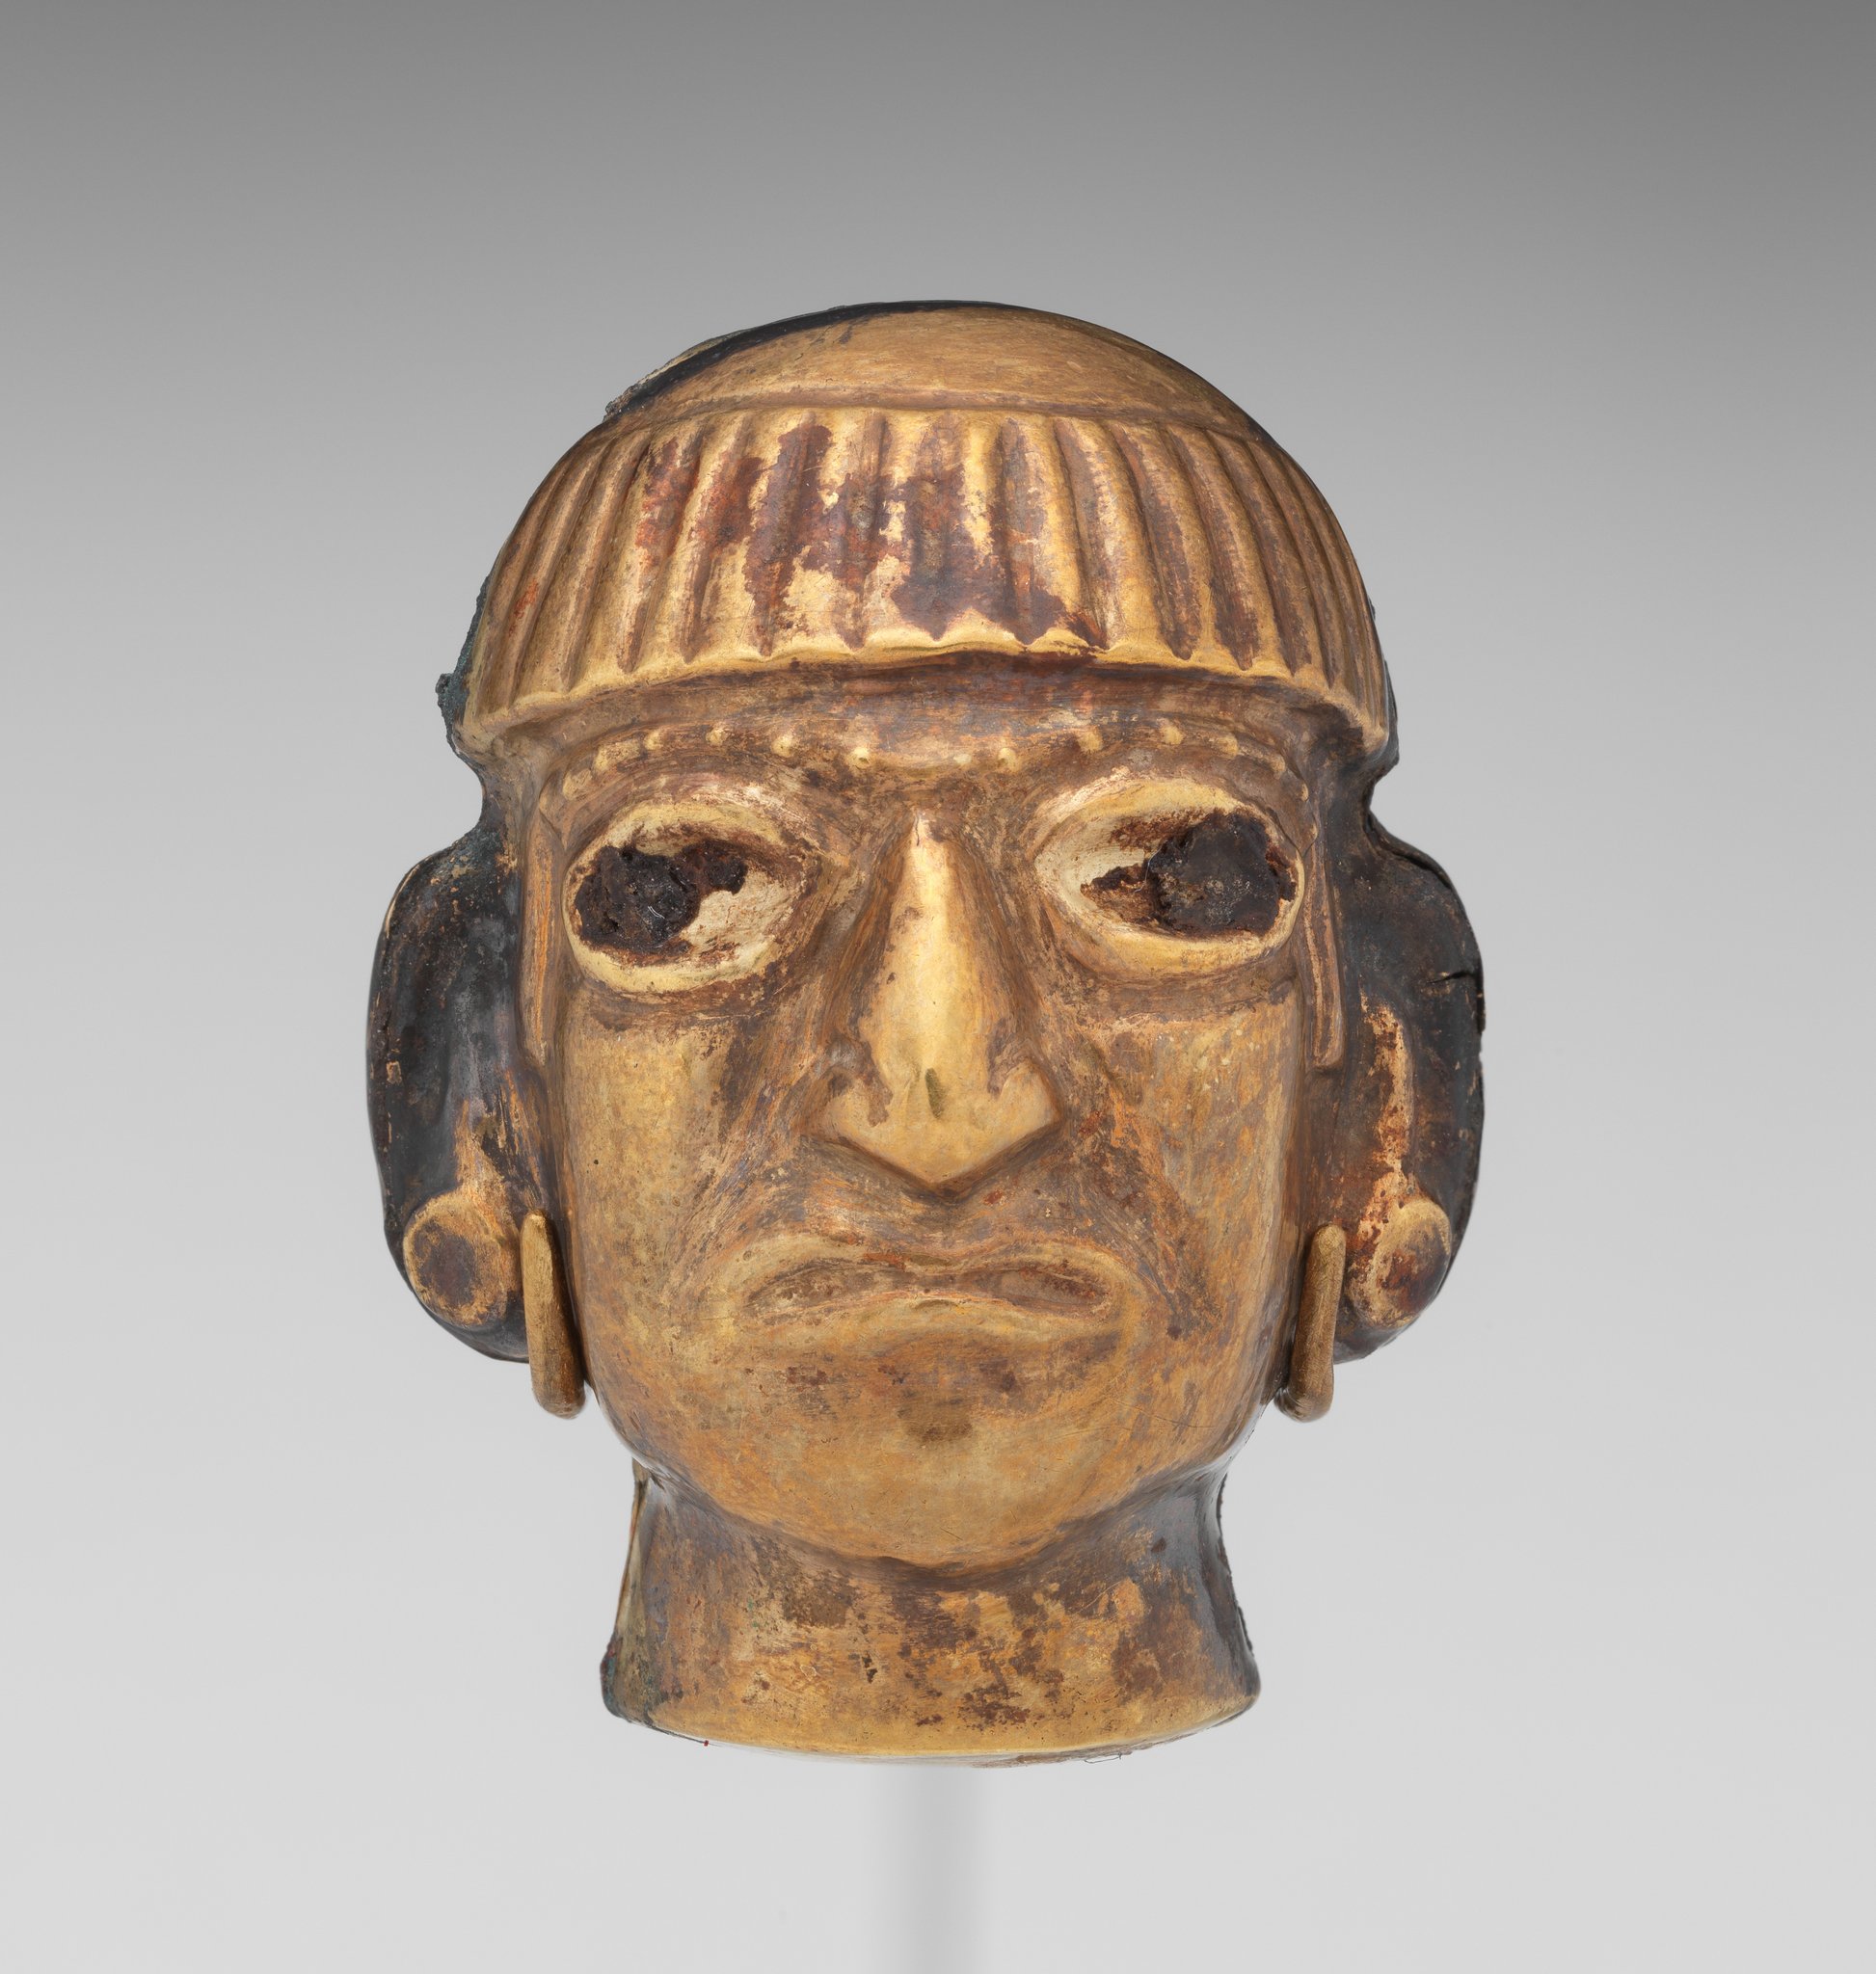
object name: bead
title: Head-shaped bead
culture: moche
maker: moche artist(s)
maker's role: artist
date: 200-800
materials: gold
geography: peru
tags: heads